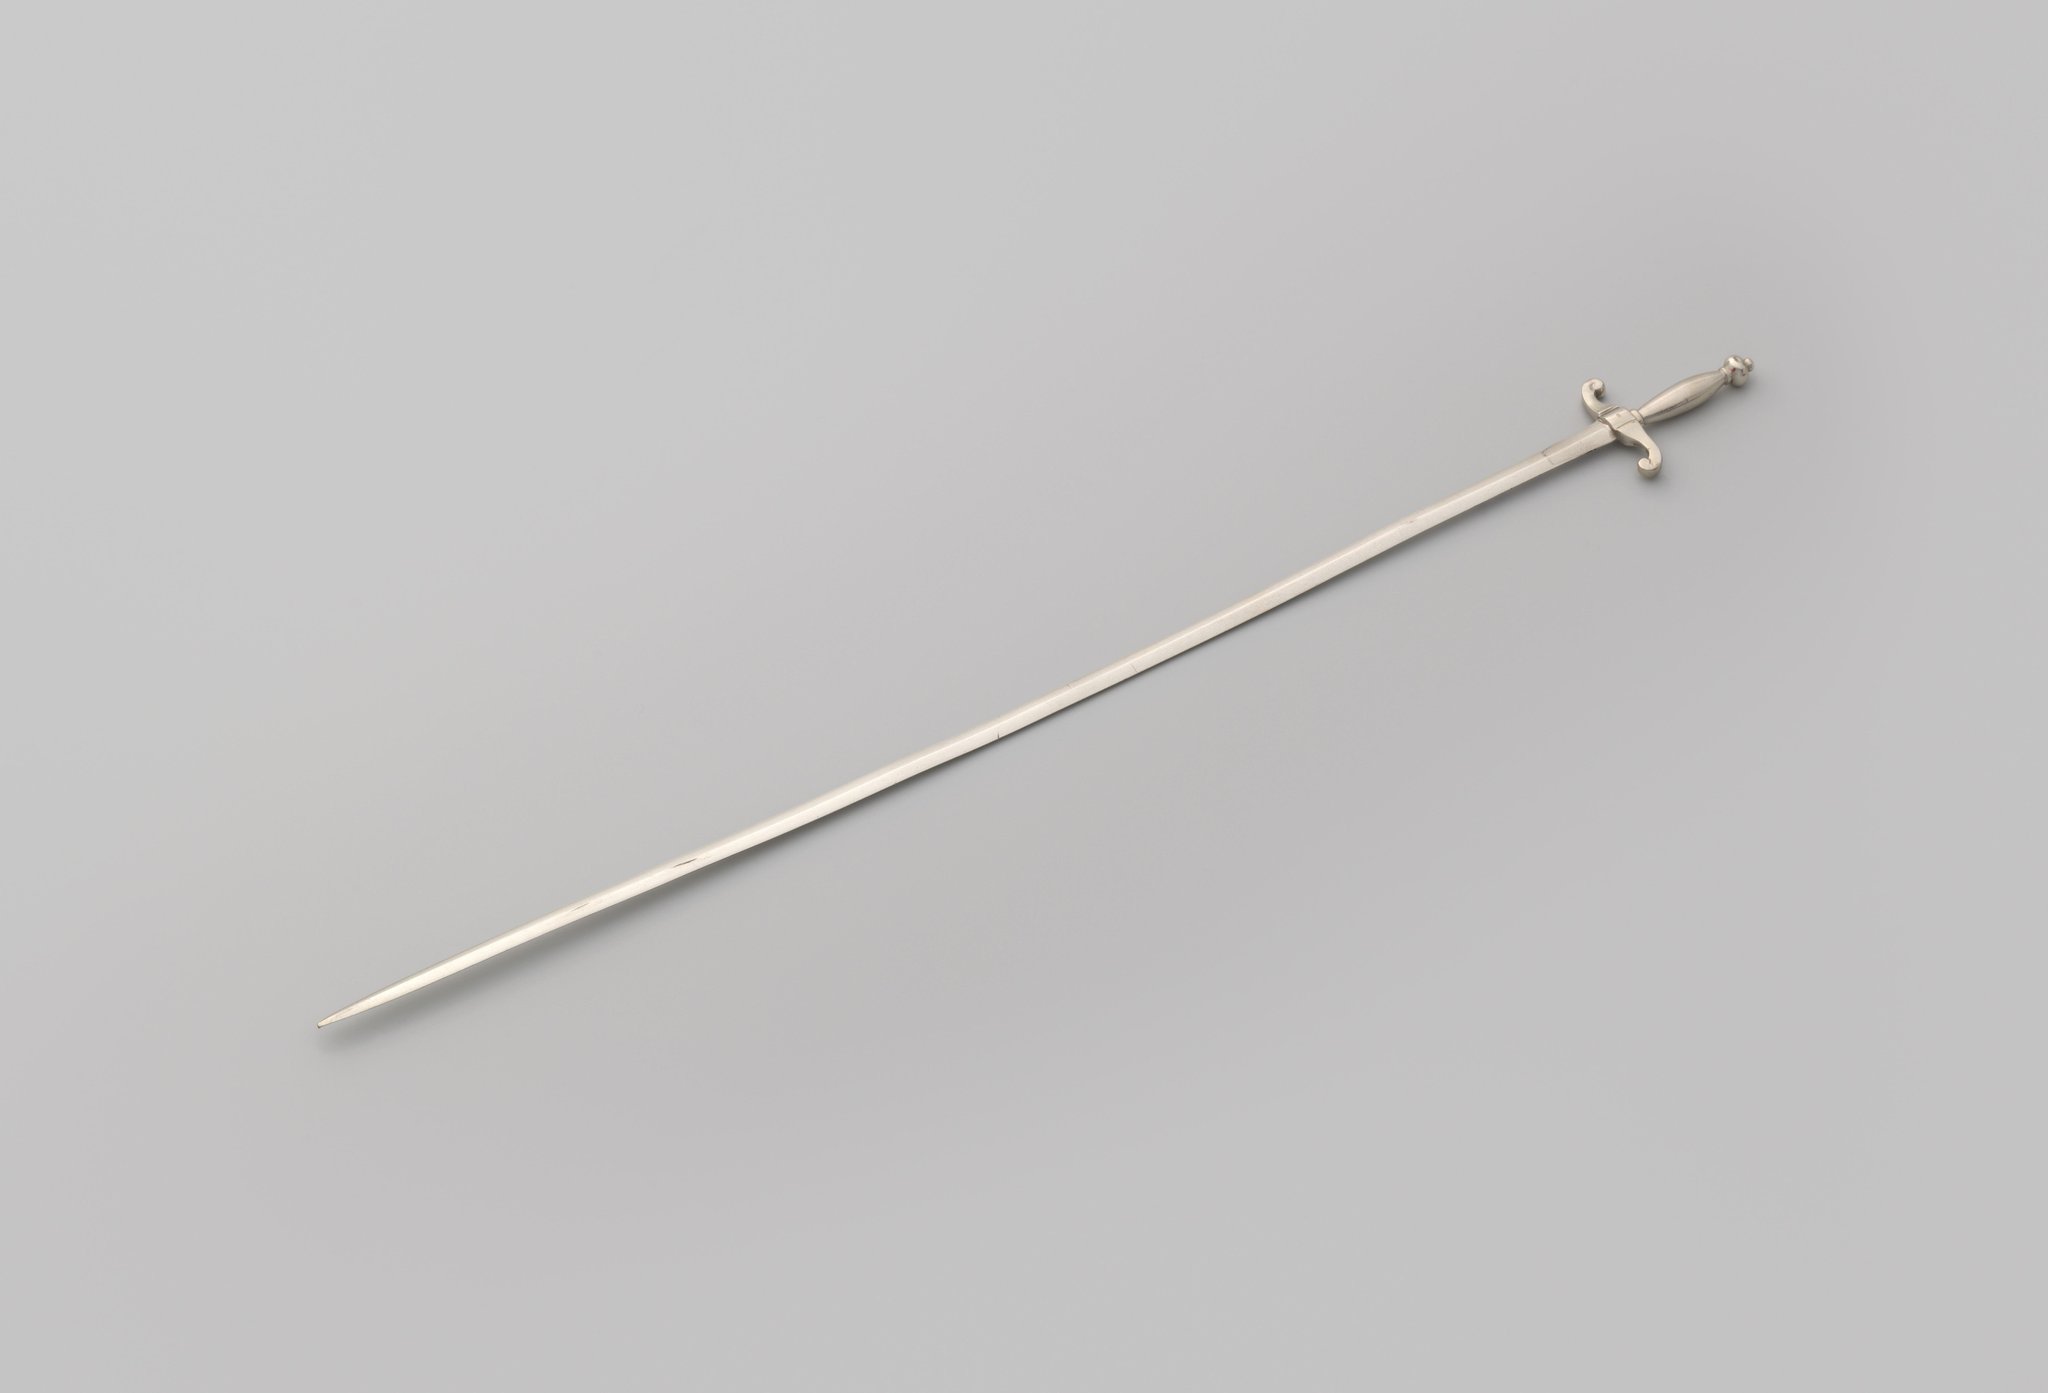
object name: skewer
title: Vleespen in de vorm van een degen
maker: johannes schiotling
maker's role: silversmith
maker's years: 1730-1799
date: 1791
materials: silver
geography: amsterdam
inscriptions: town mark, maker's mark, date letter: ‘G’, : ‘ZII’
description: De vleespennen (A en B) hebben de vorm van een degen met een lang lemmet en een gevest dat bestaat uit een uit twee voluten opgebouwde pareerstang, een langgerekt ovale greep en een bolvormige knop, bekroond door een klein knopje.